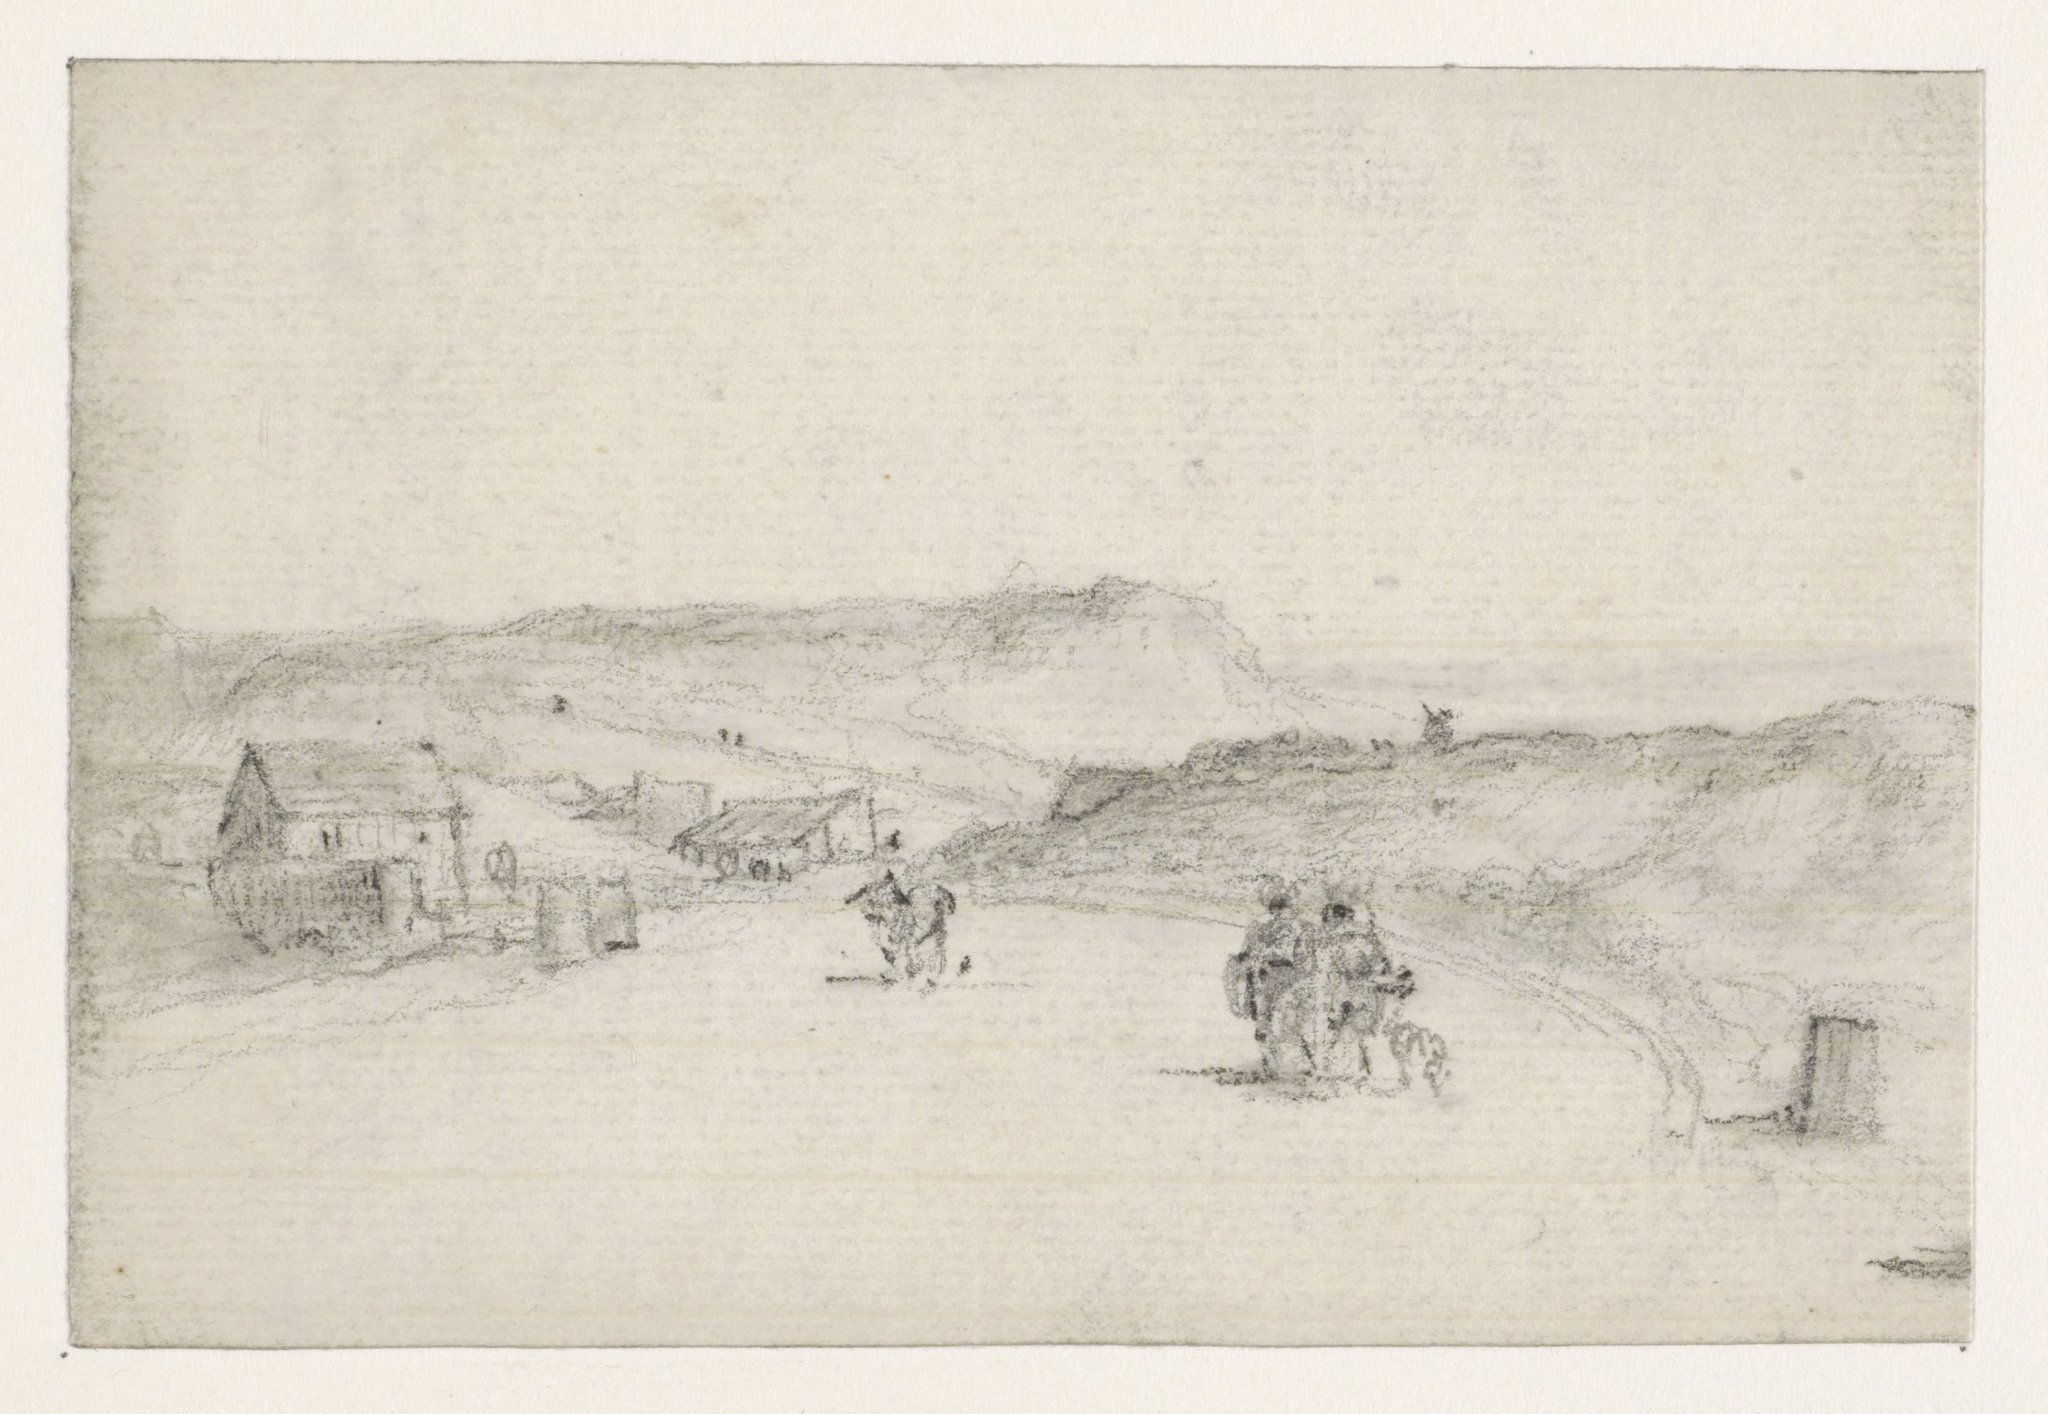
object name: drawing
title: Dalende weg tussen twee hellingen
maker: georges michel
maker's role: draughtsman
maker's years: 1763-1843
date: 1773-1843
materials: chalk, paper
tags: landscapes in the temperate zone, 'en route', traveller under way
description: Een van 120 tekeningen, afkomstig uit een 19e eeuws album met tekeningen van Georges Michel.